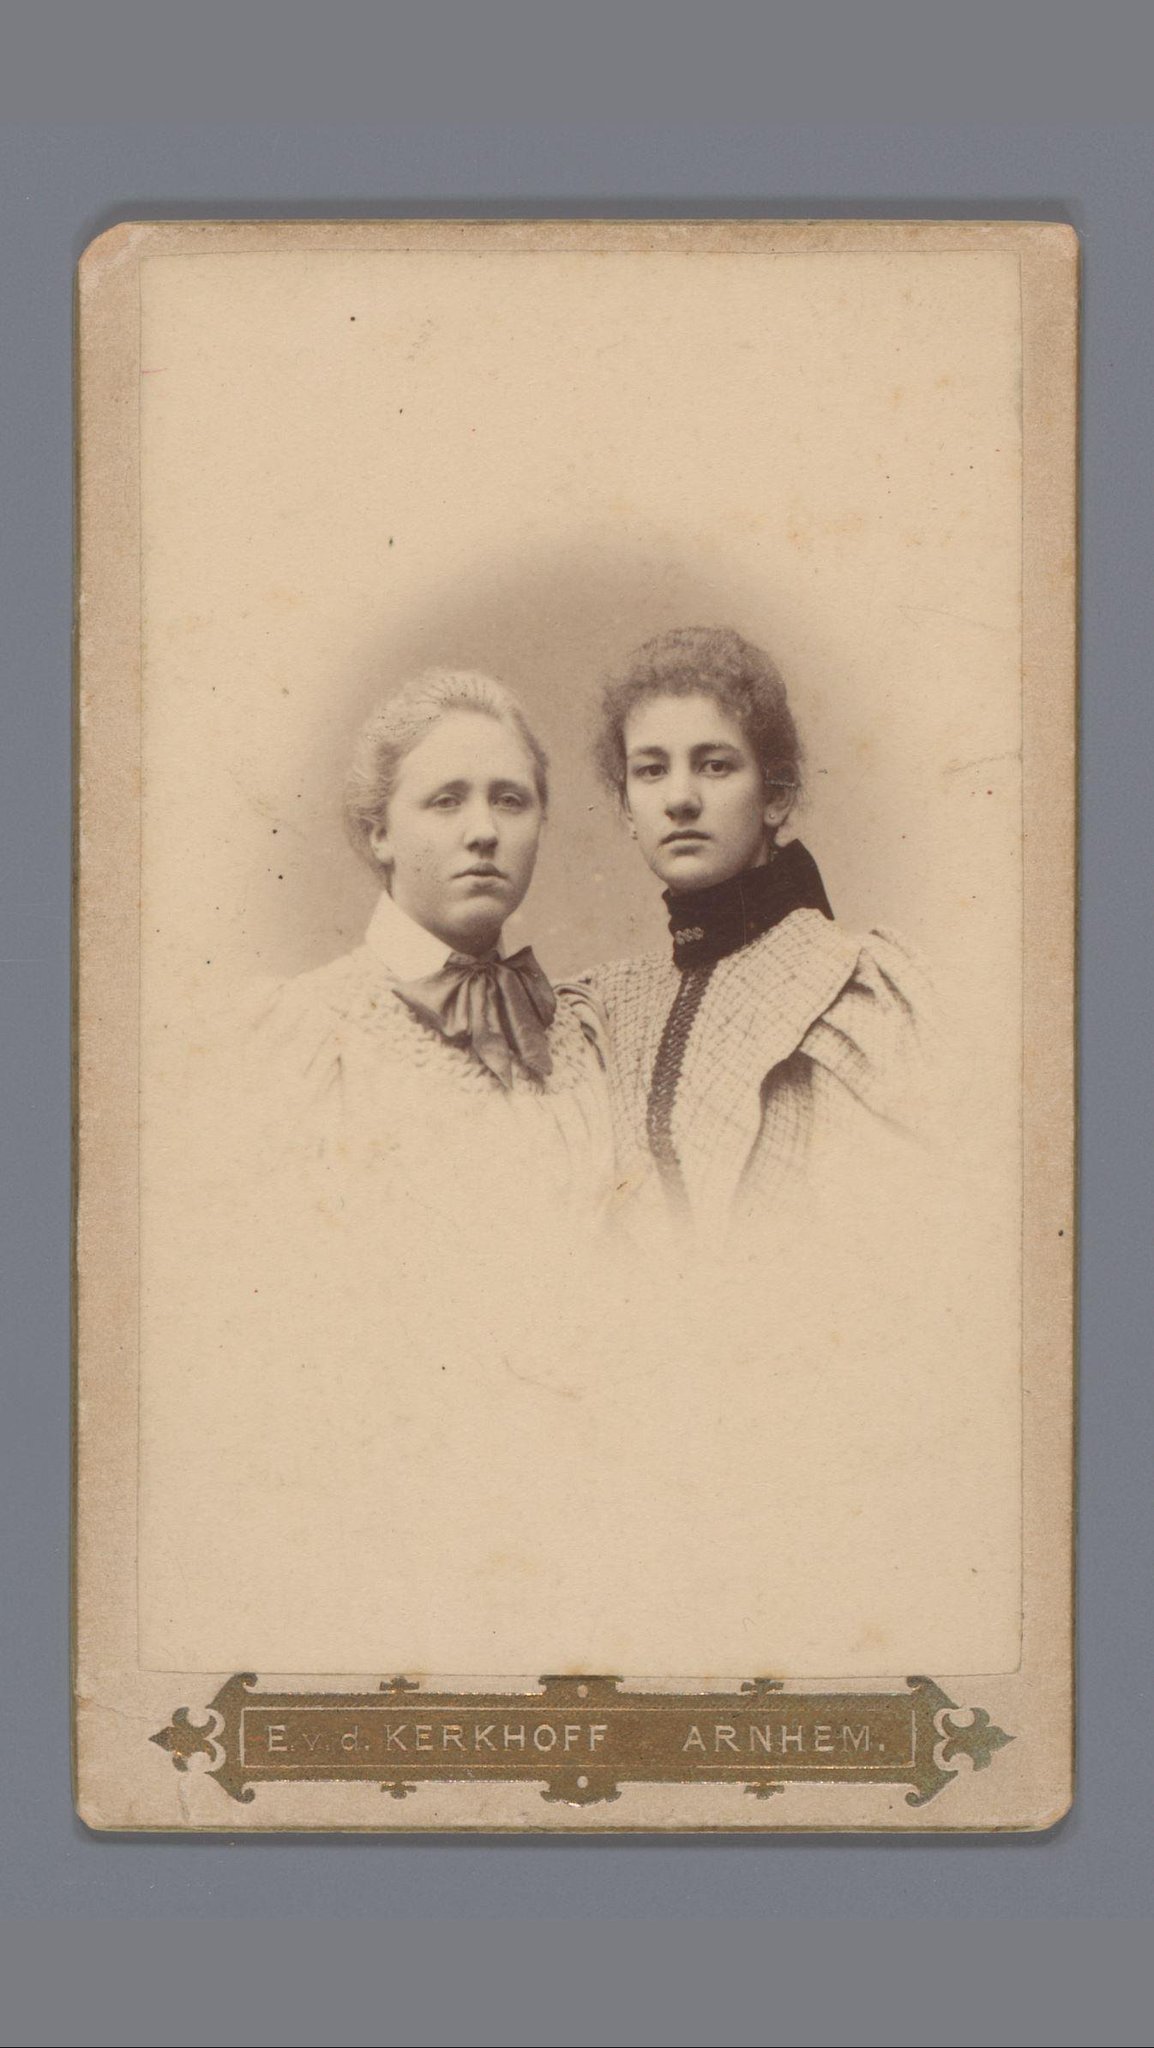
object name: photograph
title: Portret van Ida en Loes v/d Wijck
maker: e. v.d. kerkhoff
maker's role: fotograaf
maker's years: 1861-1943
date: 1895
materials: cardboard, paper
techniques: albumen print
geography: arnhem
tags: historical persons, adolescent, young woman, maiden (+ two persons)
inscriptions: inscription: ‘E. v.d. Kerkhoff/ ARNHEM/ RIdderstraat No. 27./ Negativen worden voor nabestelling bewaard./ ALEX: LINDNER. BERLIN.’, inscription: ‘Ida en/ Loes v/d Wijck./ 1895’